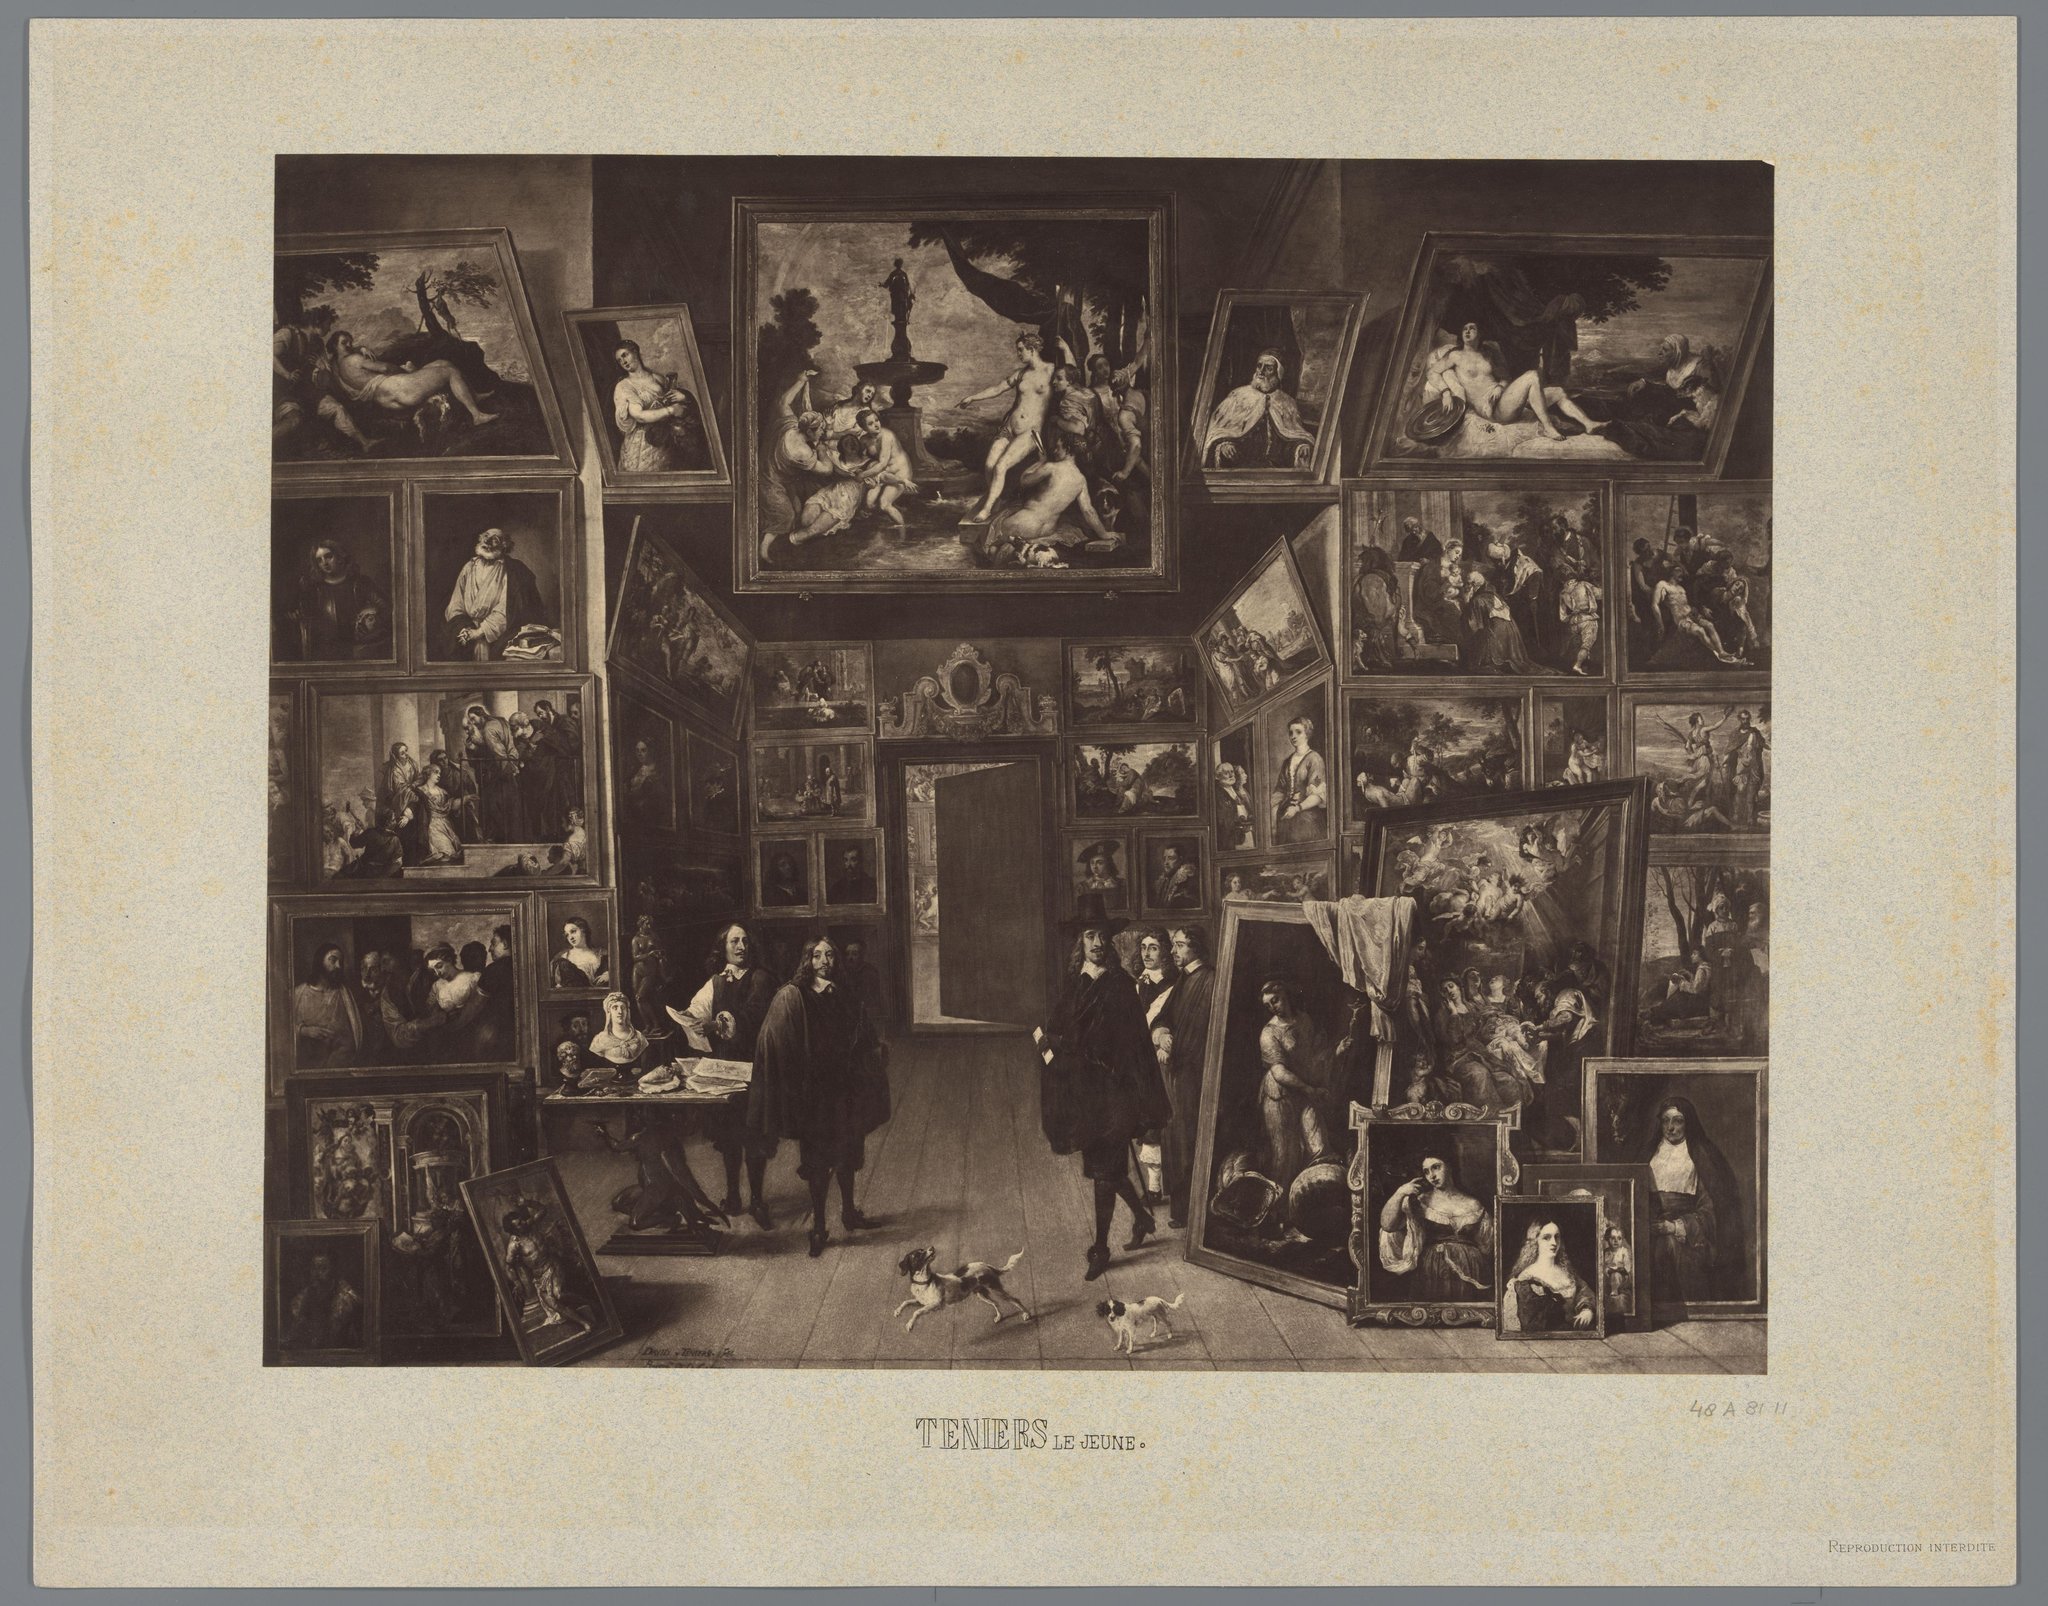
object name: photograph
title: Fotoreproductie van een schilderij van David Teniers (het huis van een schilderijenverzamelaar)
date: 1880-1900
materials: cardboard, paper, photographic support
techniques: carbon print